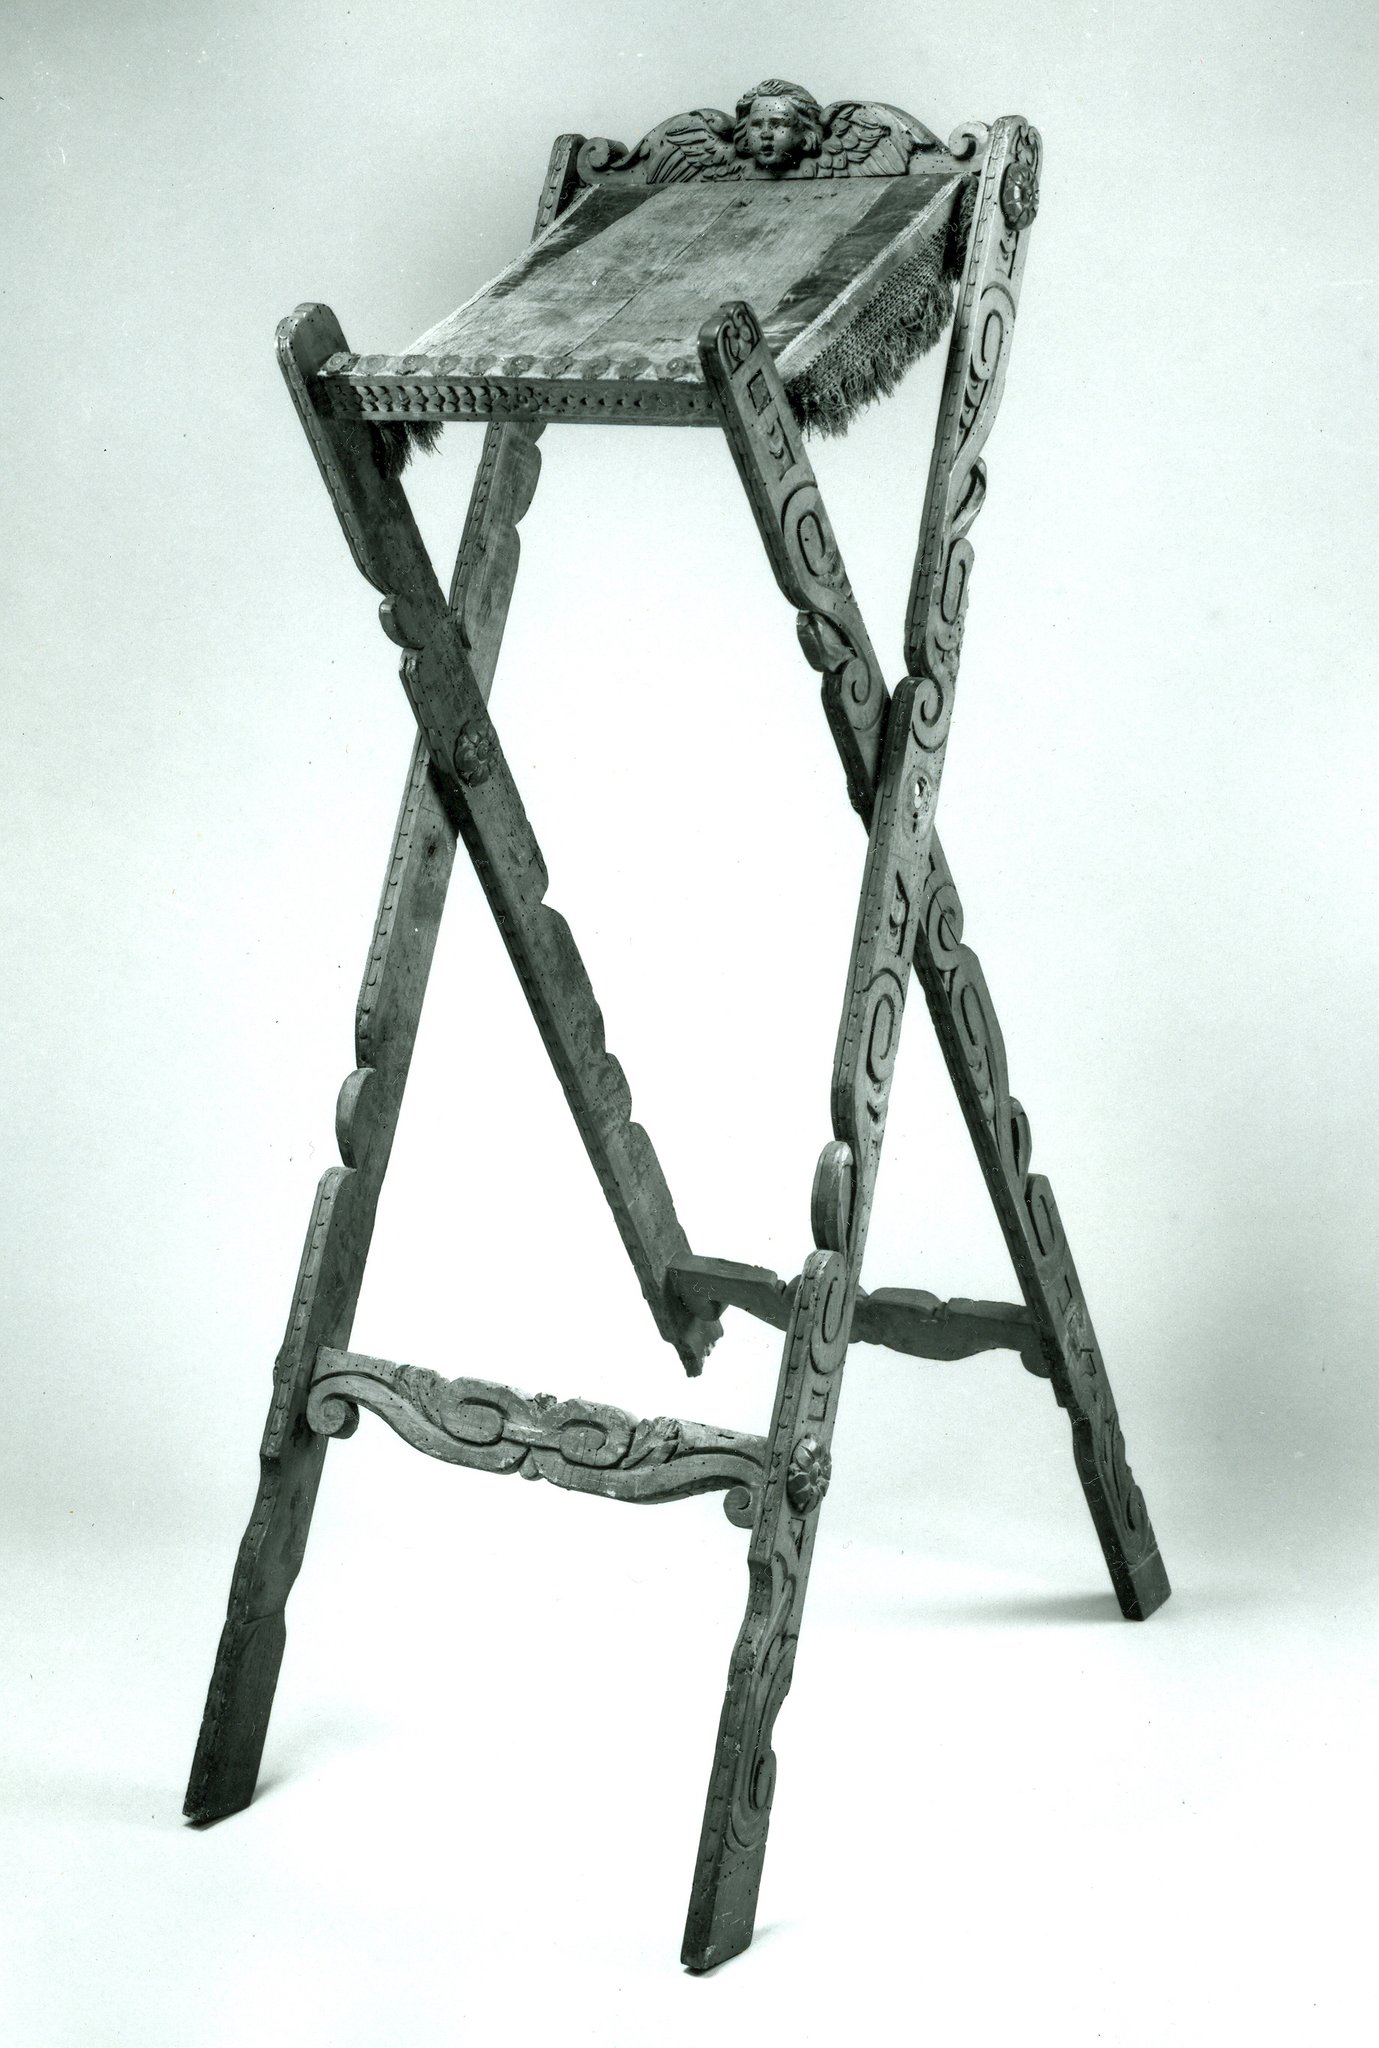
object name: lectern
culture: italian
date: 1801-1900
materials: wood